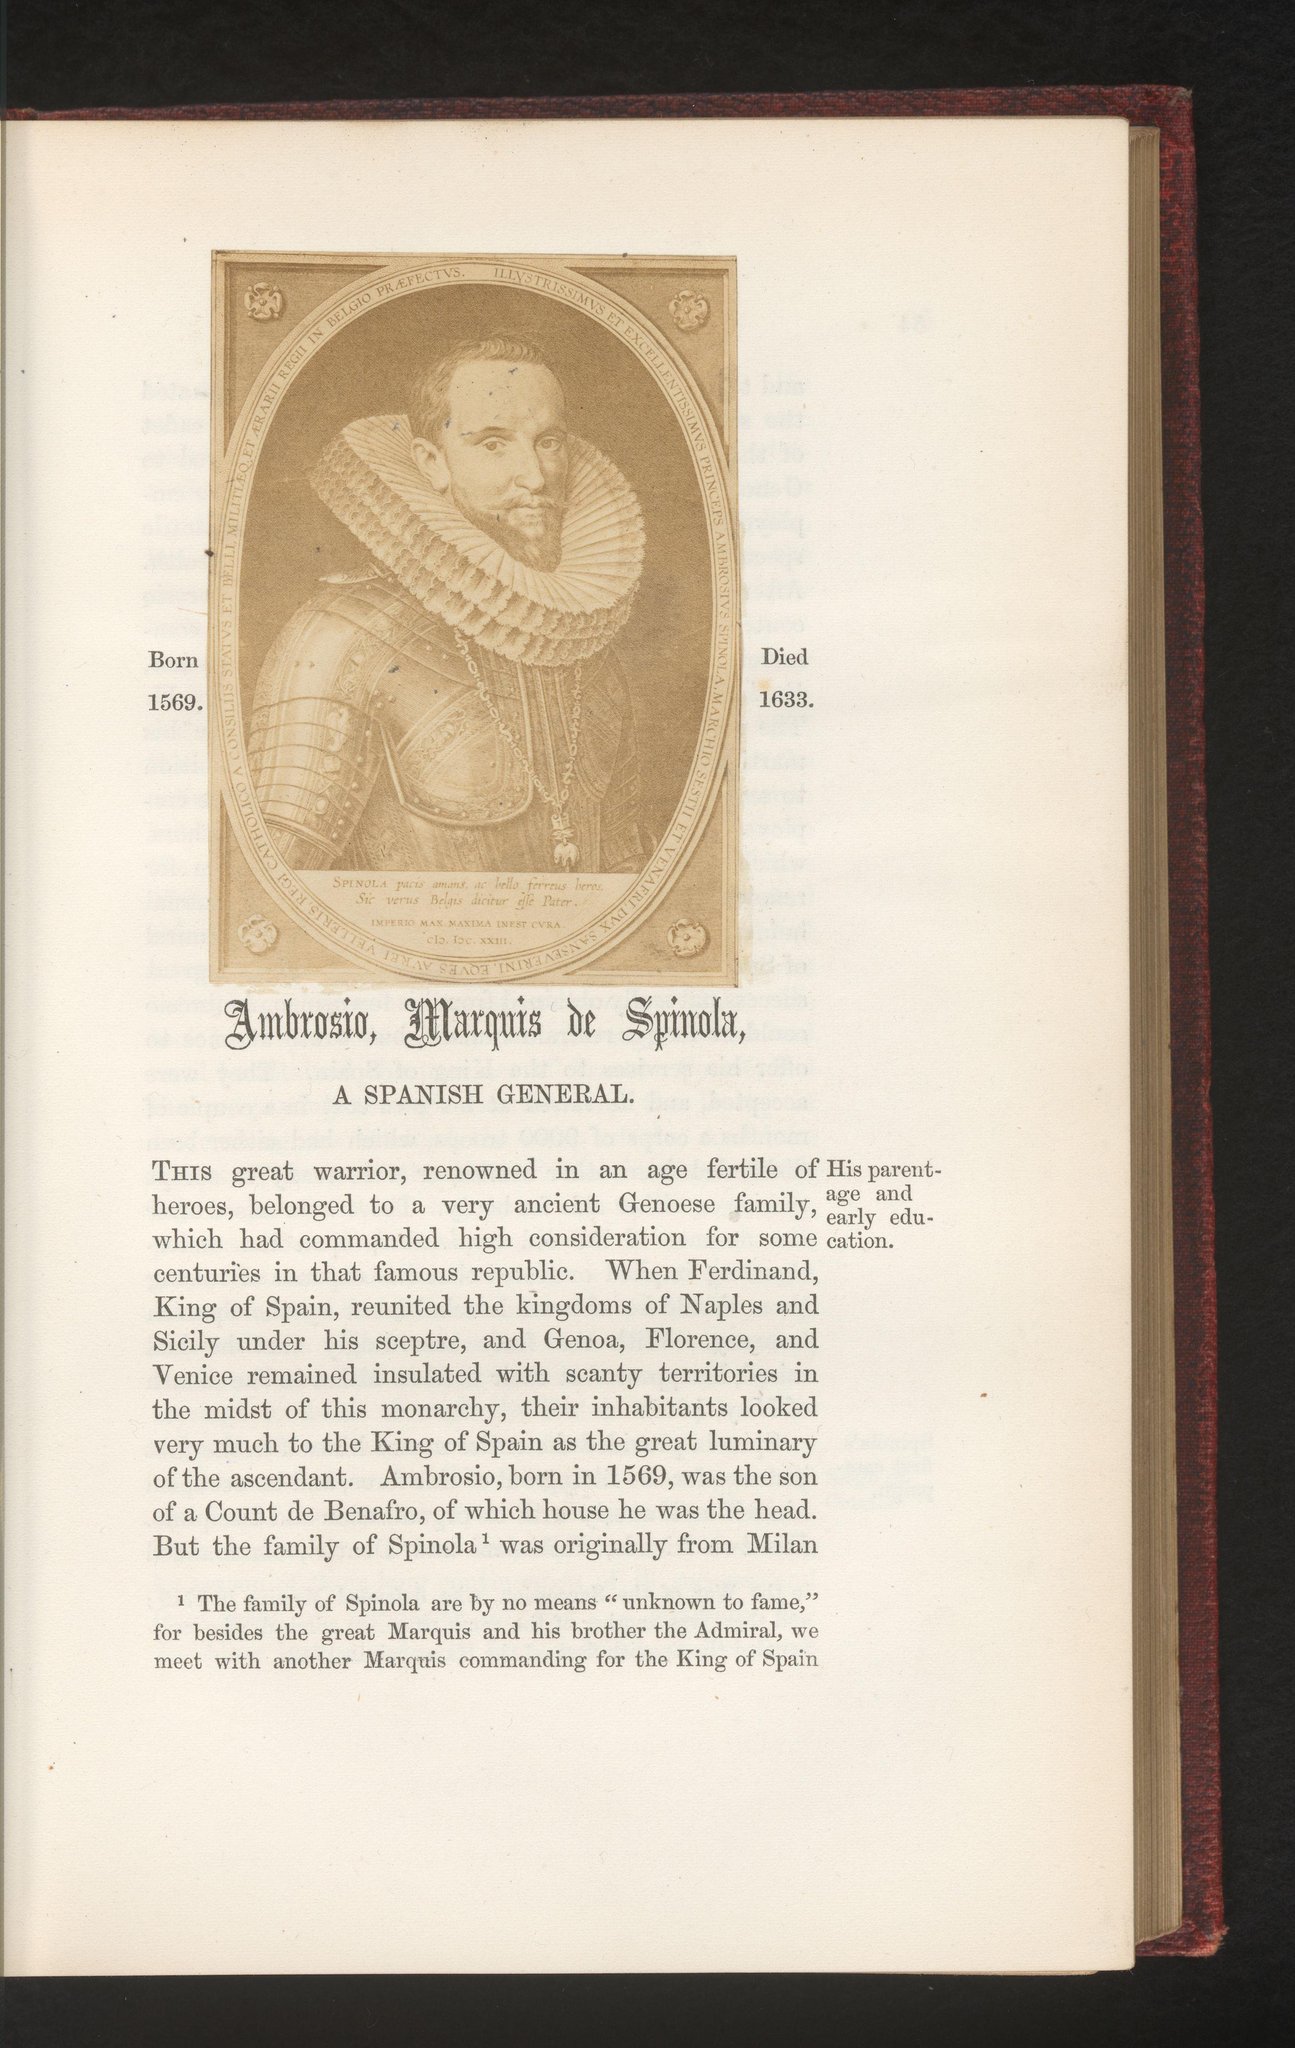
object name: reproduction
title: Fotoreproductie van een portret van Ambrogio Spinola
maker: Anonymous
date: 1860-1865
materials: photographic support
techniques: albumen print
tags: historical persons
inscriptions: inscription: ‘Born 1569/ Died 1633/ A Spanish general’